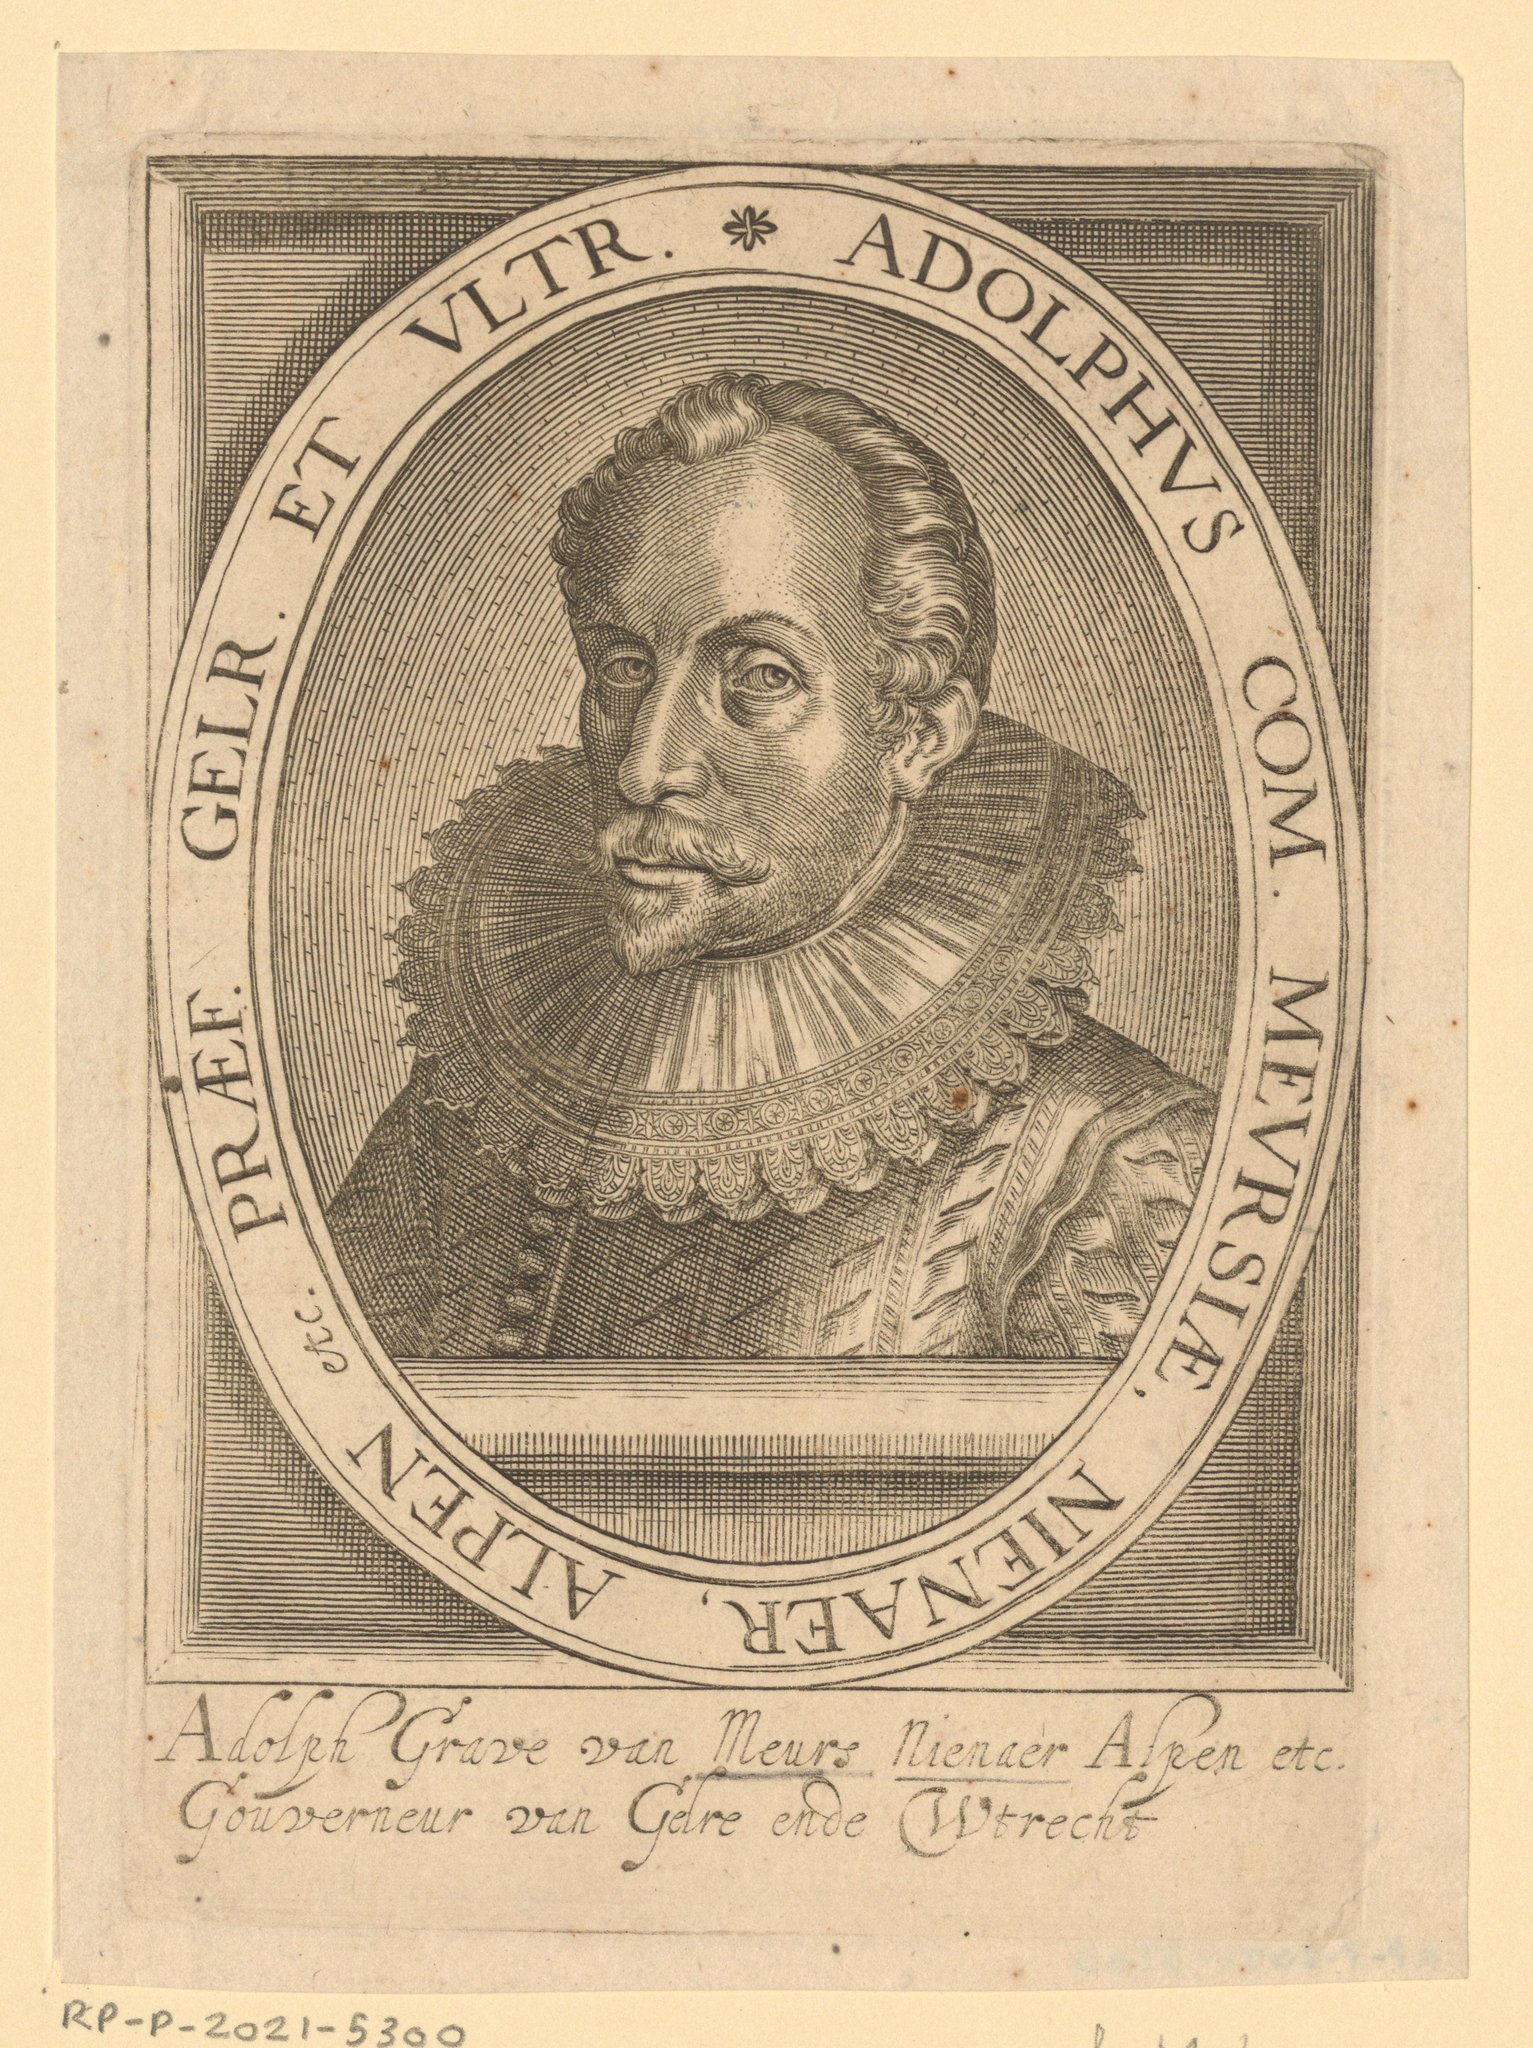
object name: print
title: Portret van Adolf graaf van Nieuwenaar en Meurs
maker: Anonymous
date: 1614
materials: paper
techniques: engraving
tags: arnhem, commander-in-chief, general, marshal, historical persons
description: Prent met tekst op verso gebruikt in: Meteren, Emanuel van. Historie der Nederlandscher ende haerder na-buren oorlogen ende geschiedenissen (...). Den Haag: Hillebrant Iacobsz. van Wouw, 1614. Prent mogelijk ook gebruikt in eerdere en latere edities.